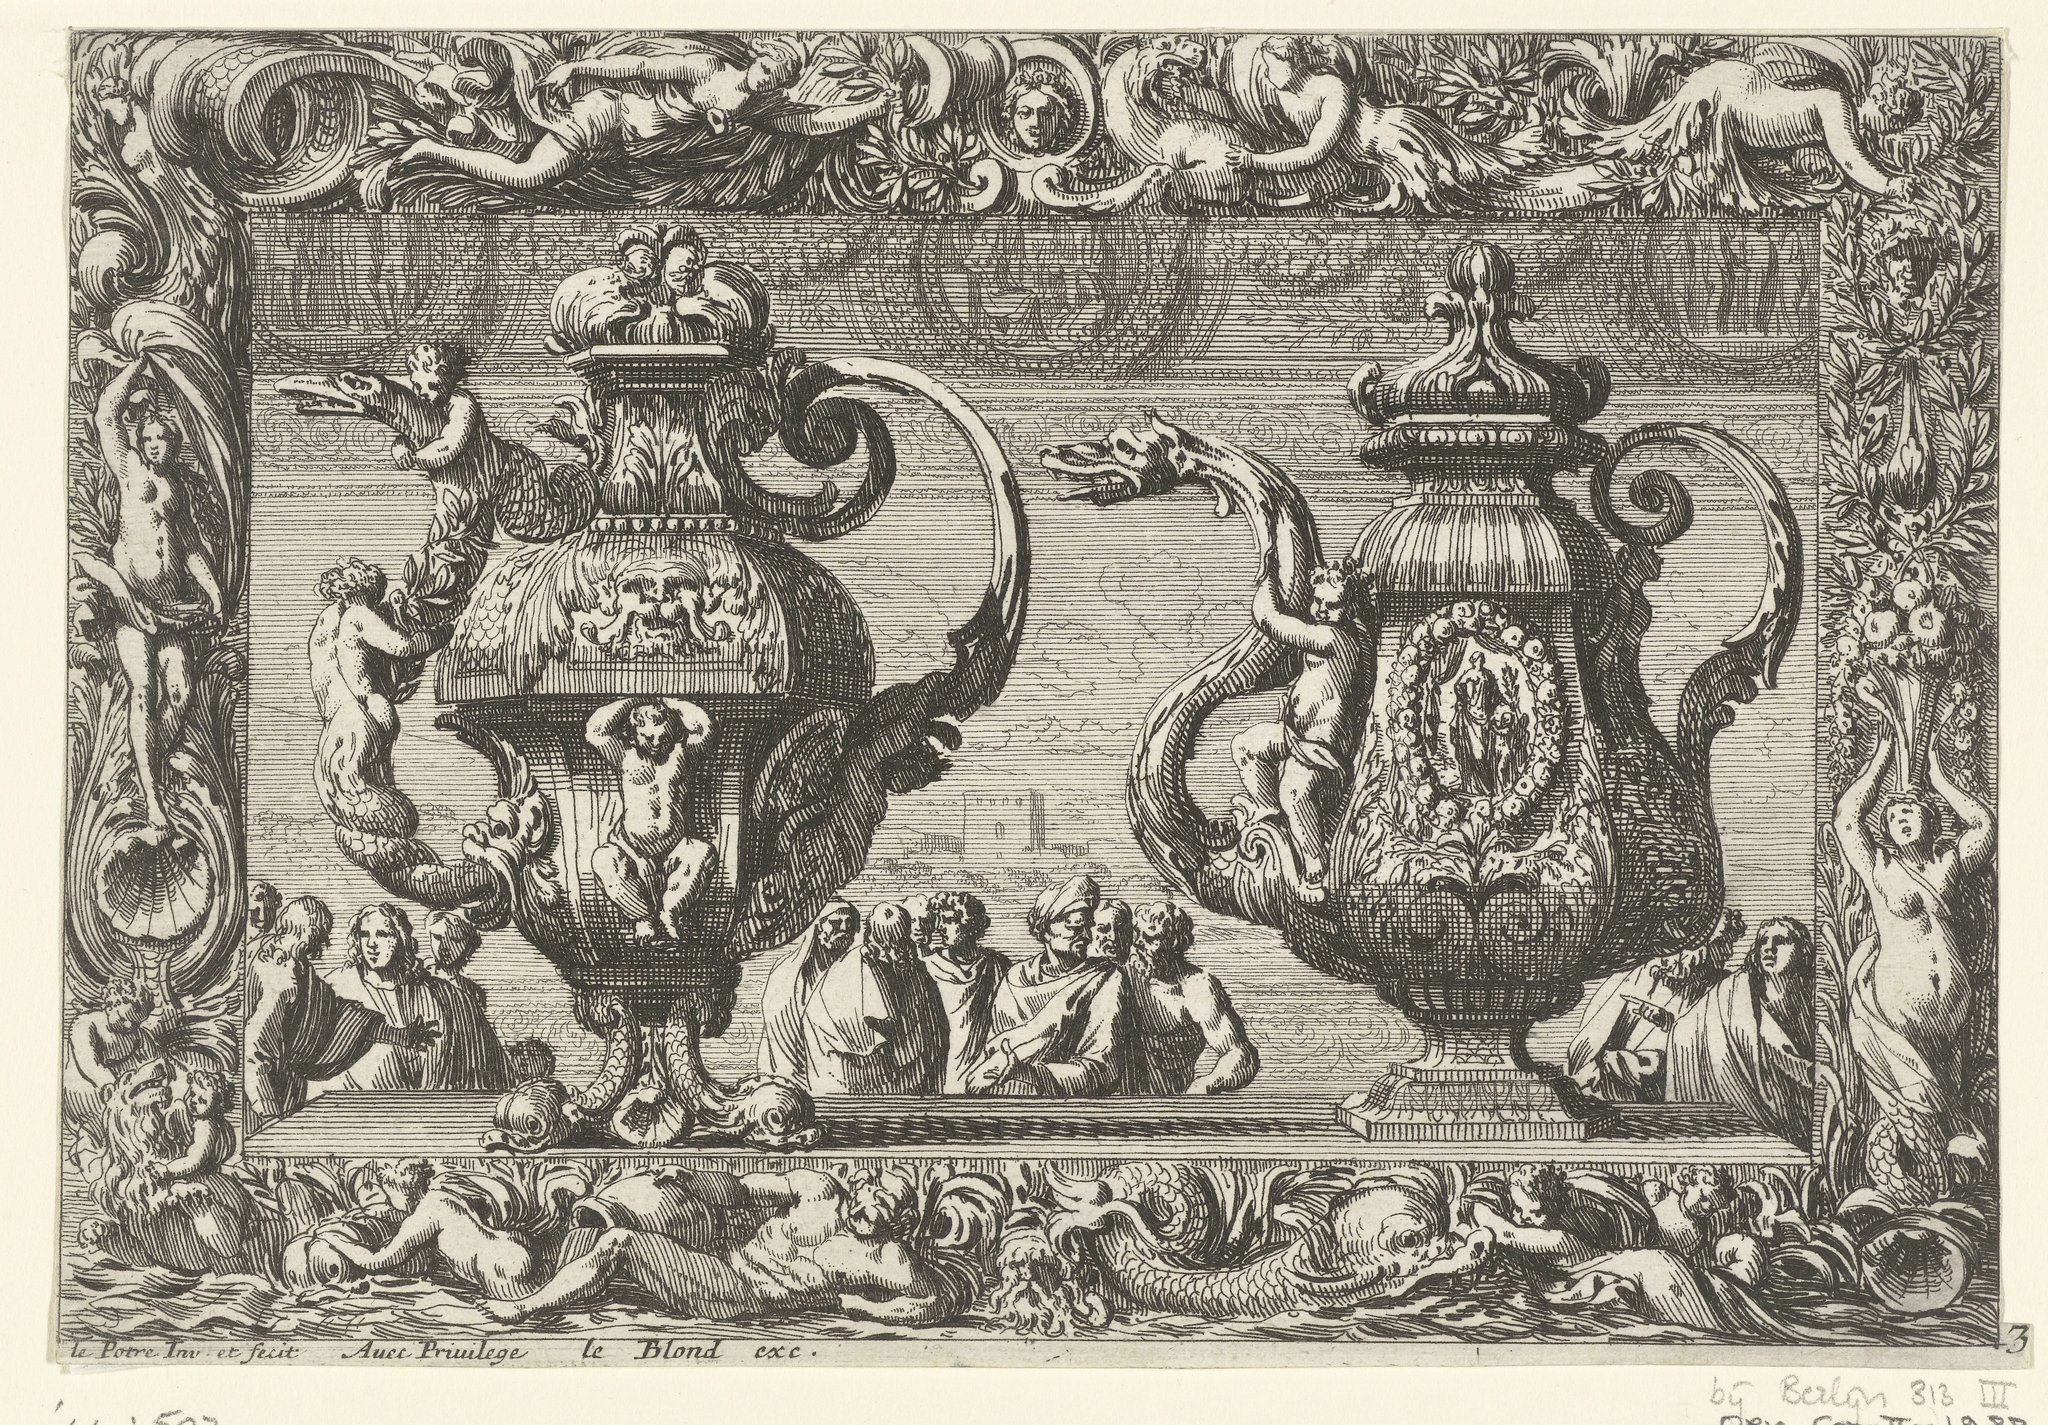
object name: ornament print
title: Schenkkannen in ornamentele lijsten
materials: paper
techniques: etching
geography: paris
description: De kannen wijzen naar links, onderaan in de lijst zijn een riviergod en een dolfijn te zien. Uit tweede editie.